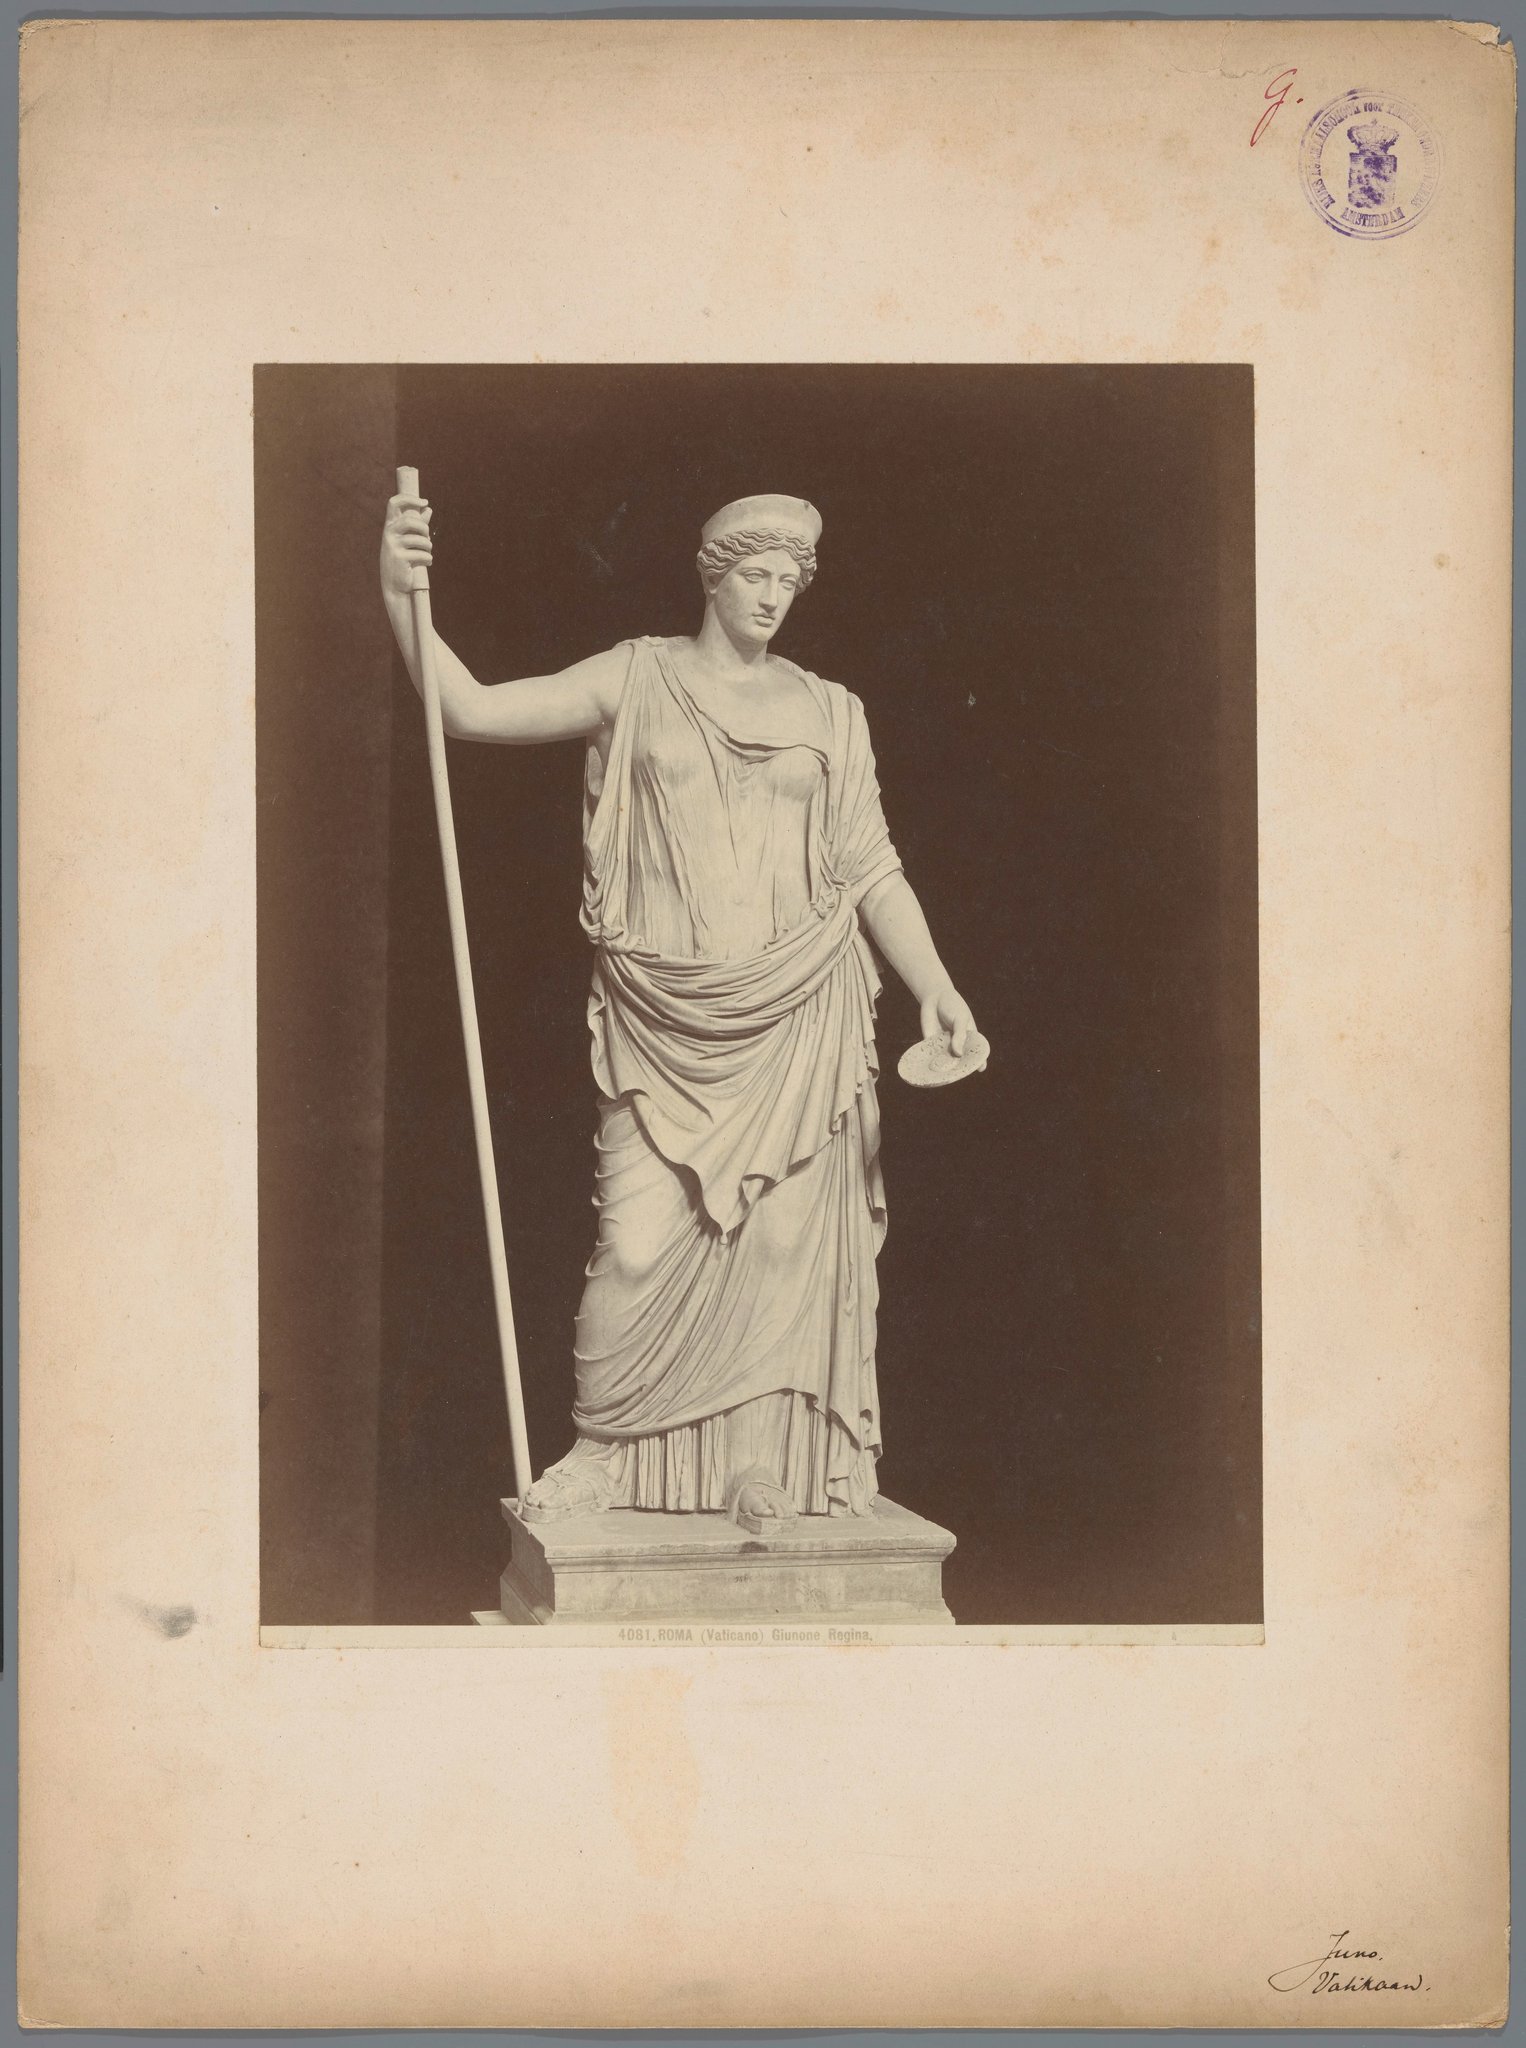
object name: photograph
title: Beeld van Juno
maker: Anonymous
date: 1850-1900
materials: cardboard, photographic support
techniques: albumen print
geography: vatican city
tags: (story of) juno (hera)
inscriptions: inscription: ‘G.’, number: ‘4081.’, collector's mark: ‘Rijks normaalschool voor teekenonderwijzers Amsterdam’, inscription: ‘ROMA’